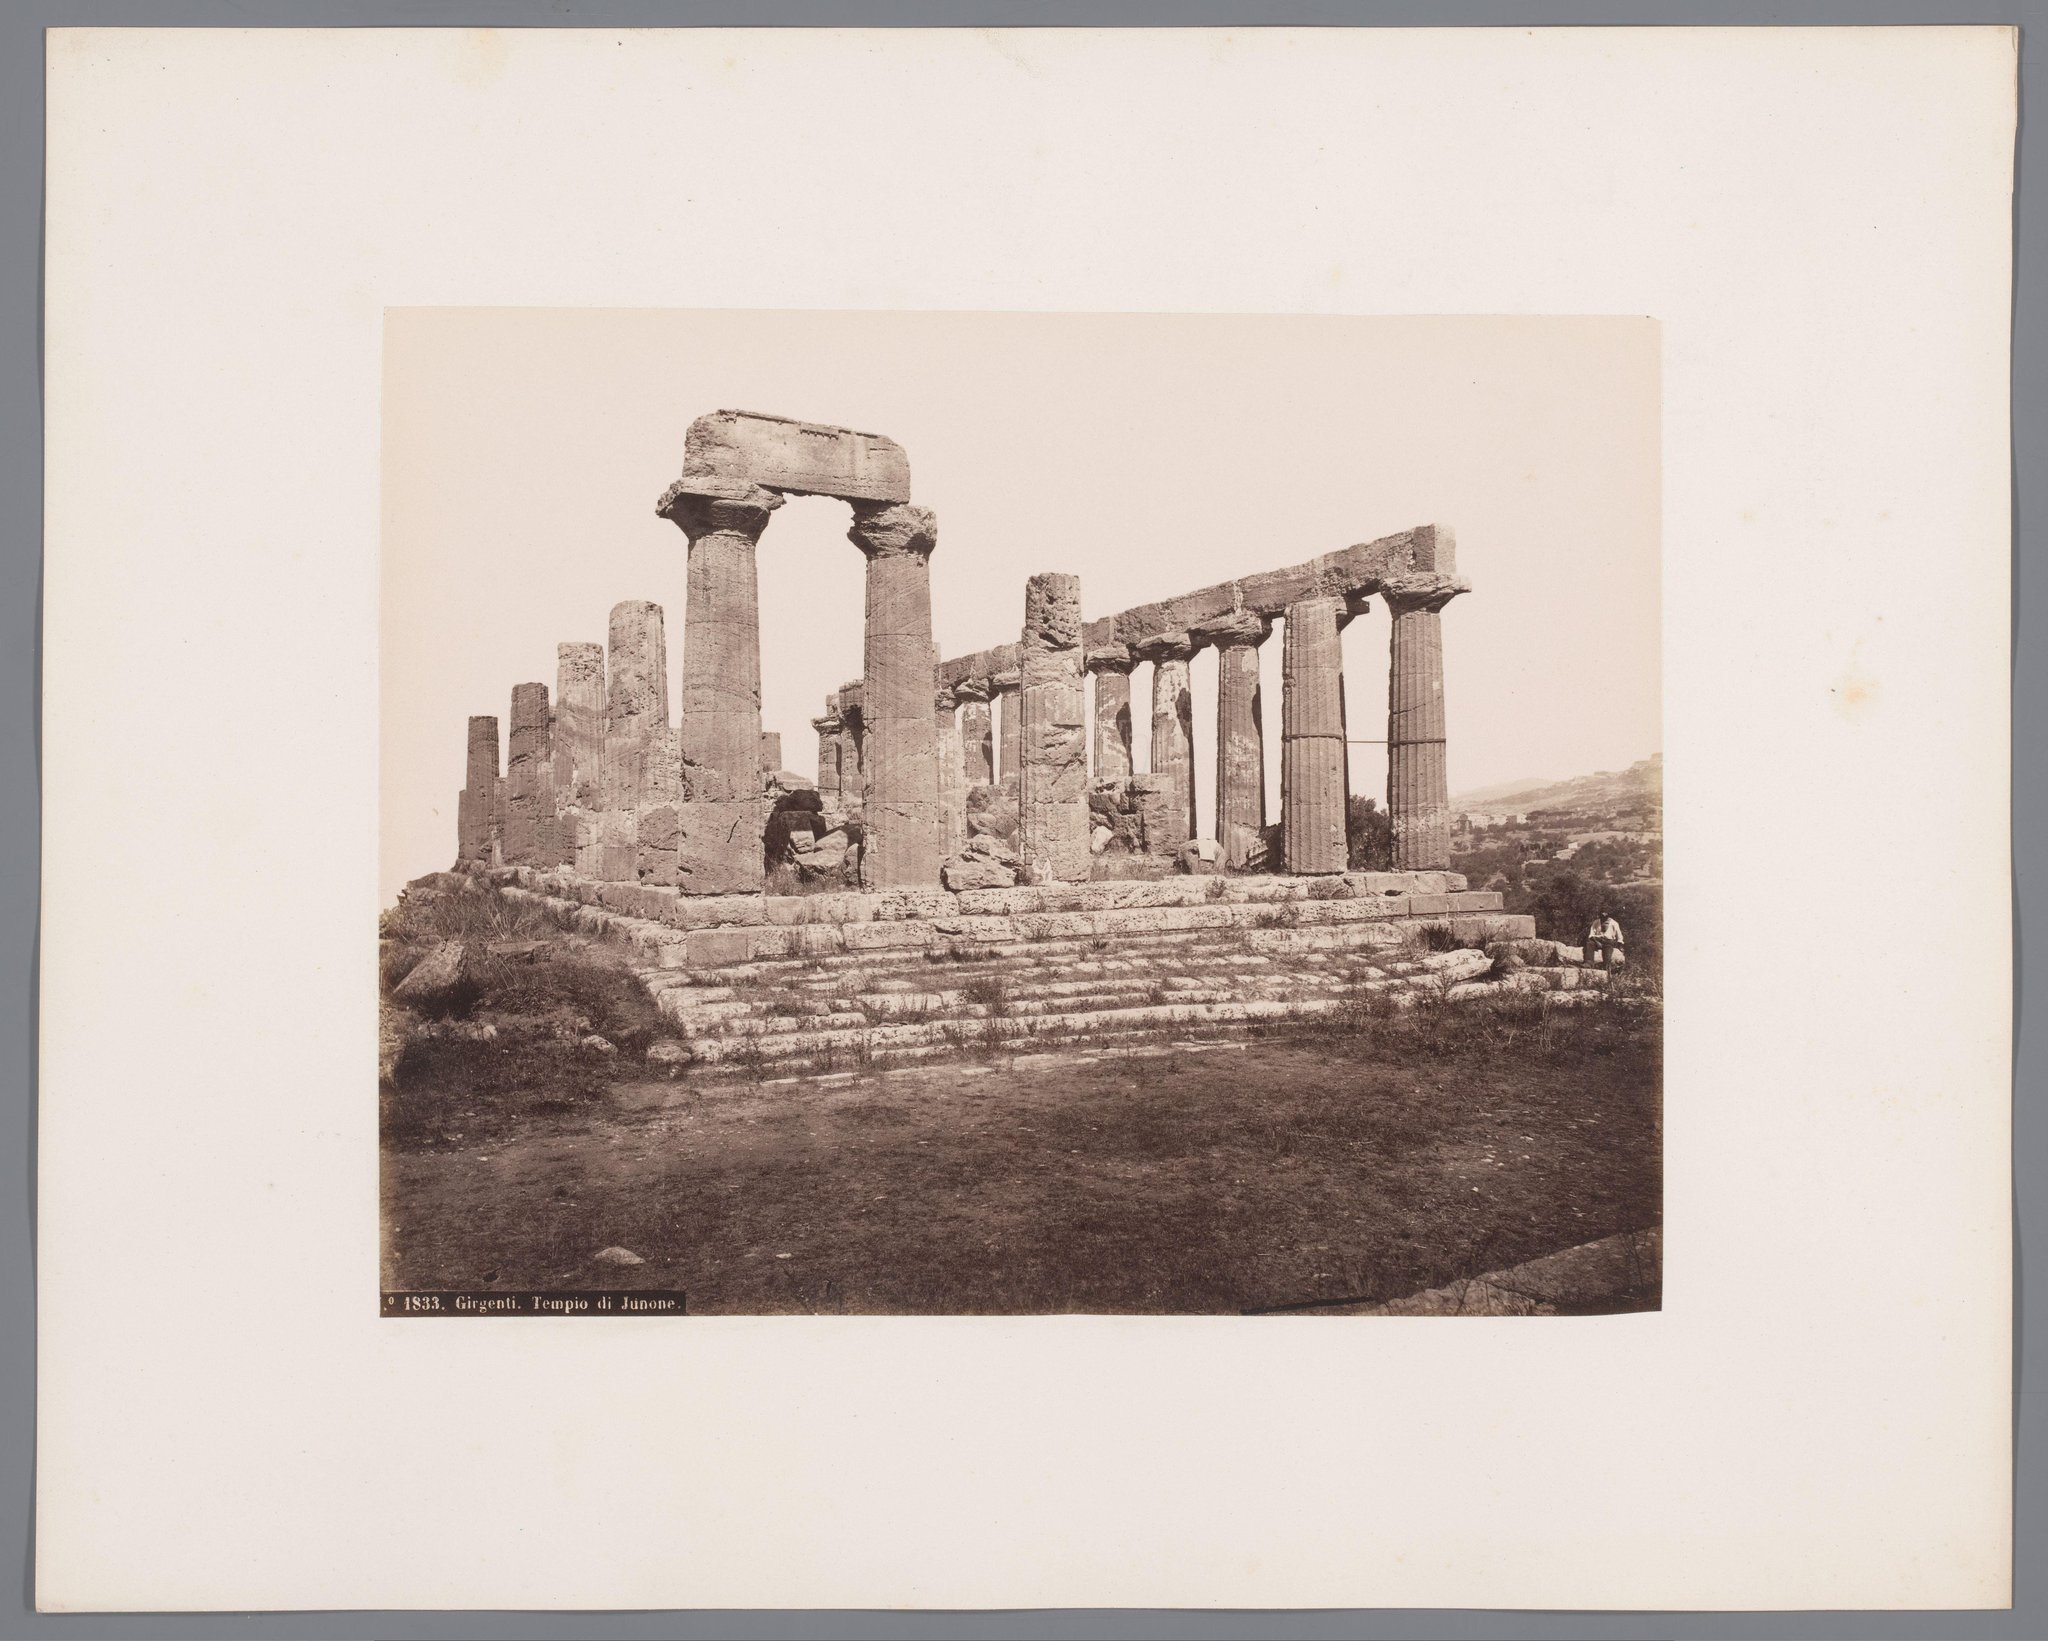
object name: photograph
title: Ruïne van de tempel van Hera Lacinia te Agrigento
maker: roberto rive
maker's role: fotograaf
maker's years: 1825-1868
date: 1860-1889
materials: cardboard, paper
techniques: albumen print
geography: agrigento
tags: ruin of a building ~ architecture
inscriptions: number: ‘No. 1833.’, inscription: ‘Rive (t)’